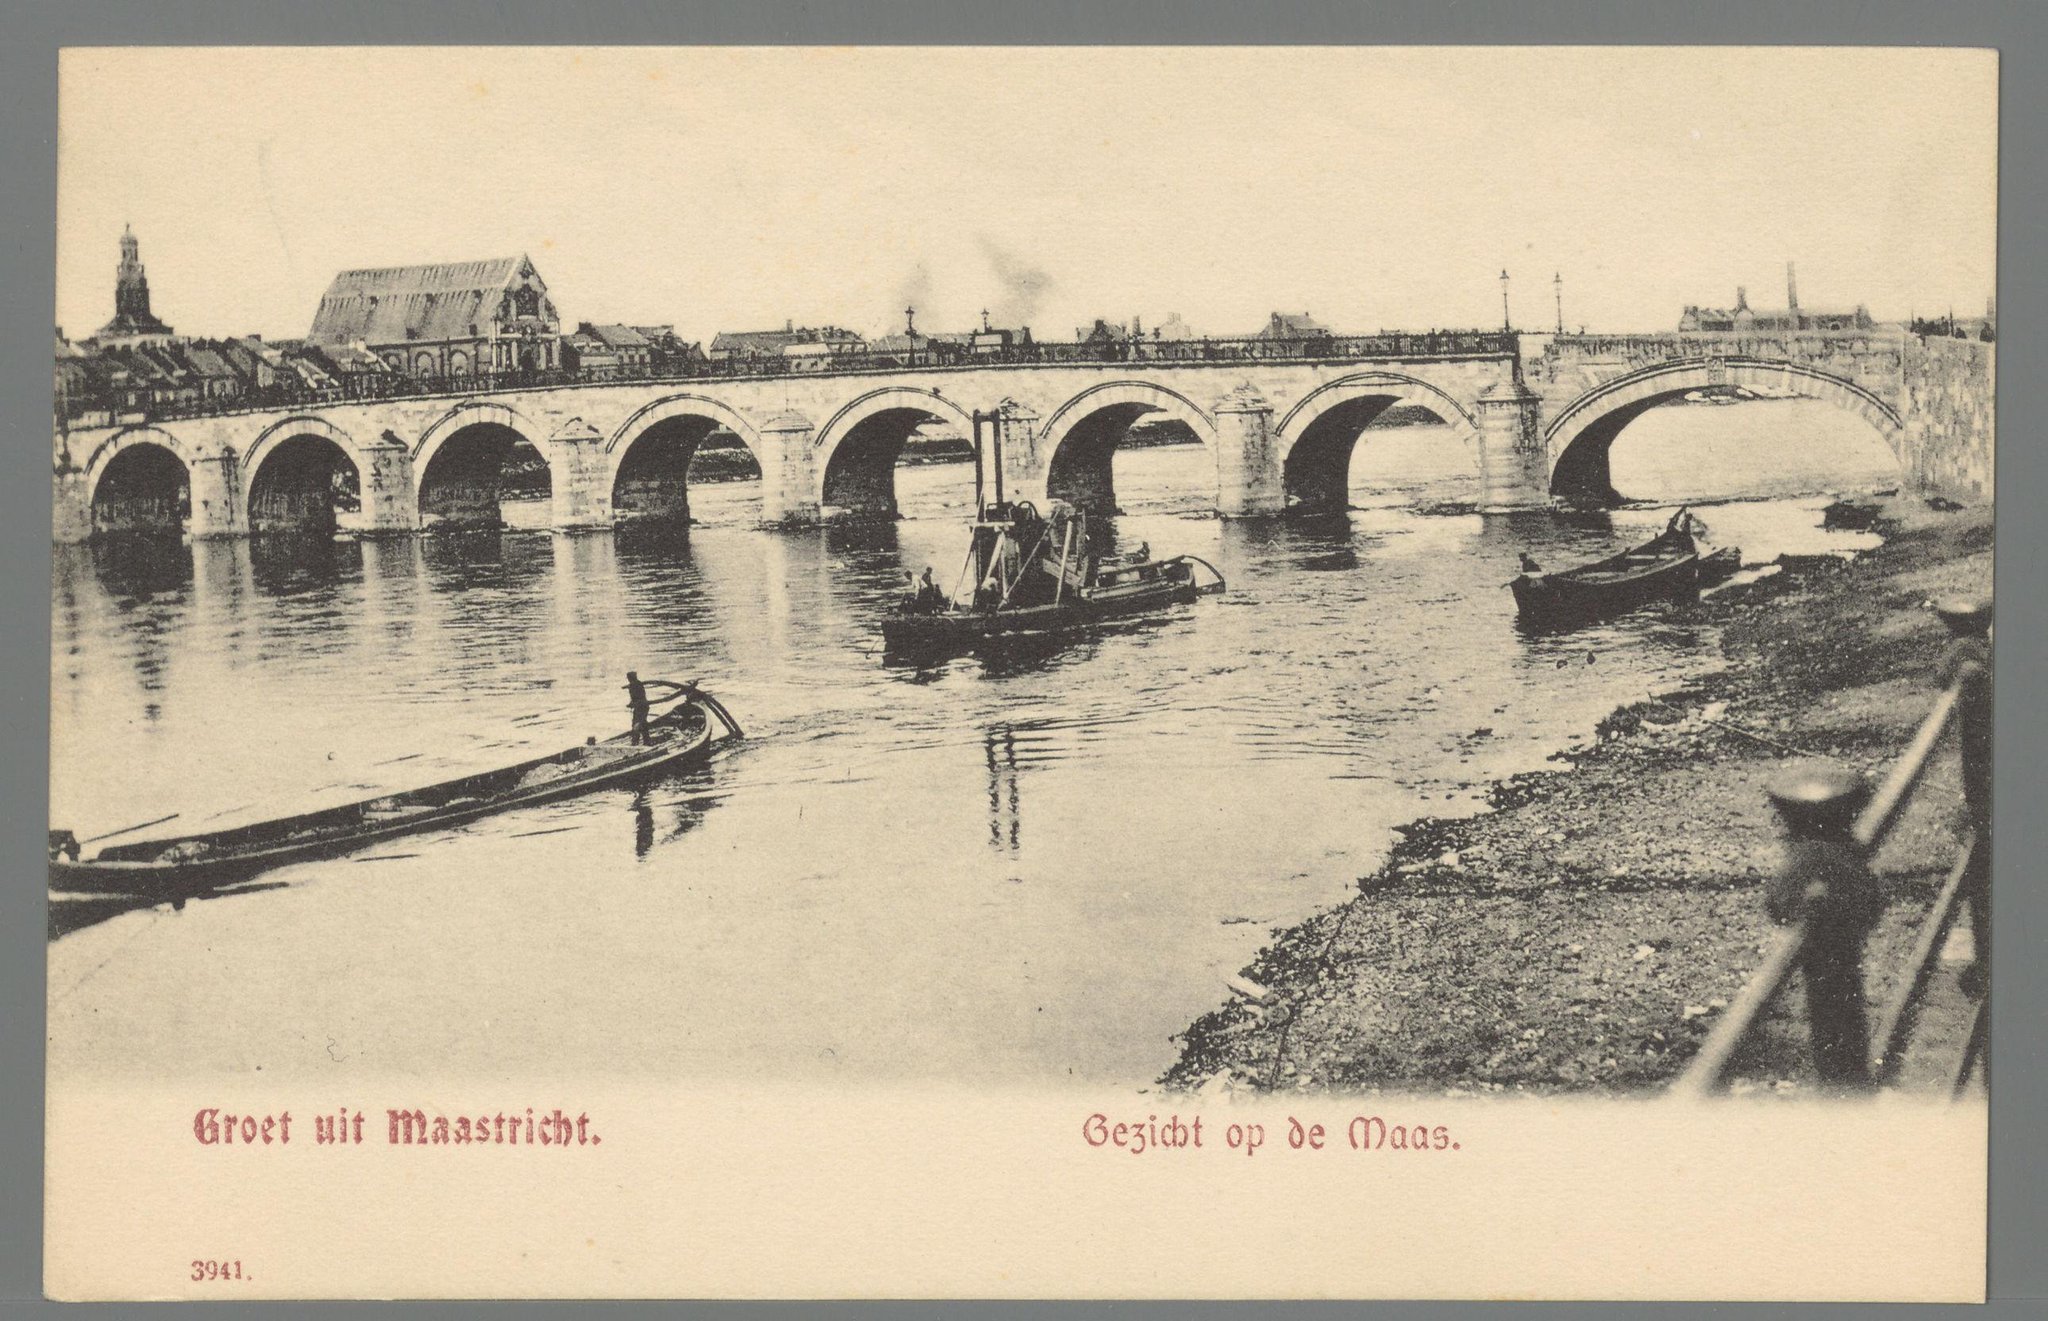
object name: ansichtkaart, prentbriefkaart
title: Groet uit Maastricht. Gezicht op de Maas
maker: Anonymous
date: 1897-1905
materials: cardboard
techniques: photograph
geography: maastricht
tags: customs, bridge in village across river, canal, etc.